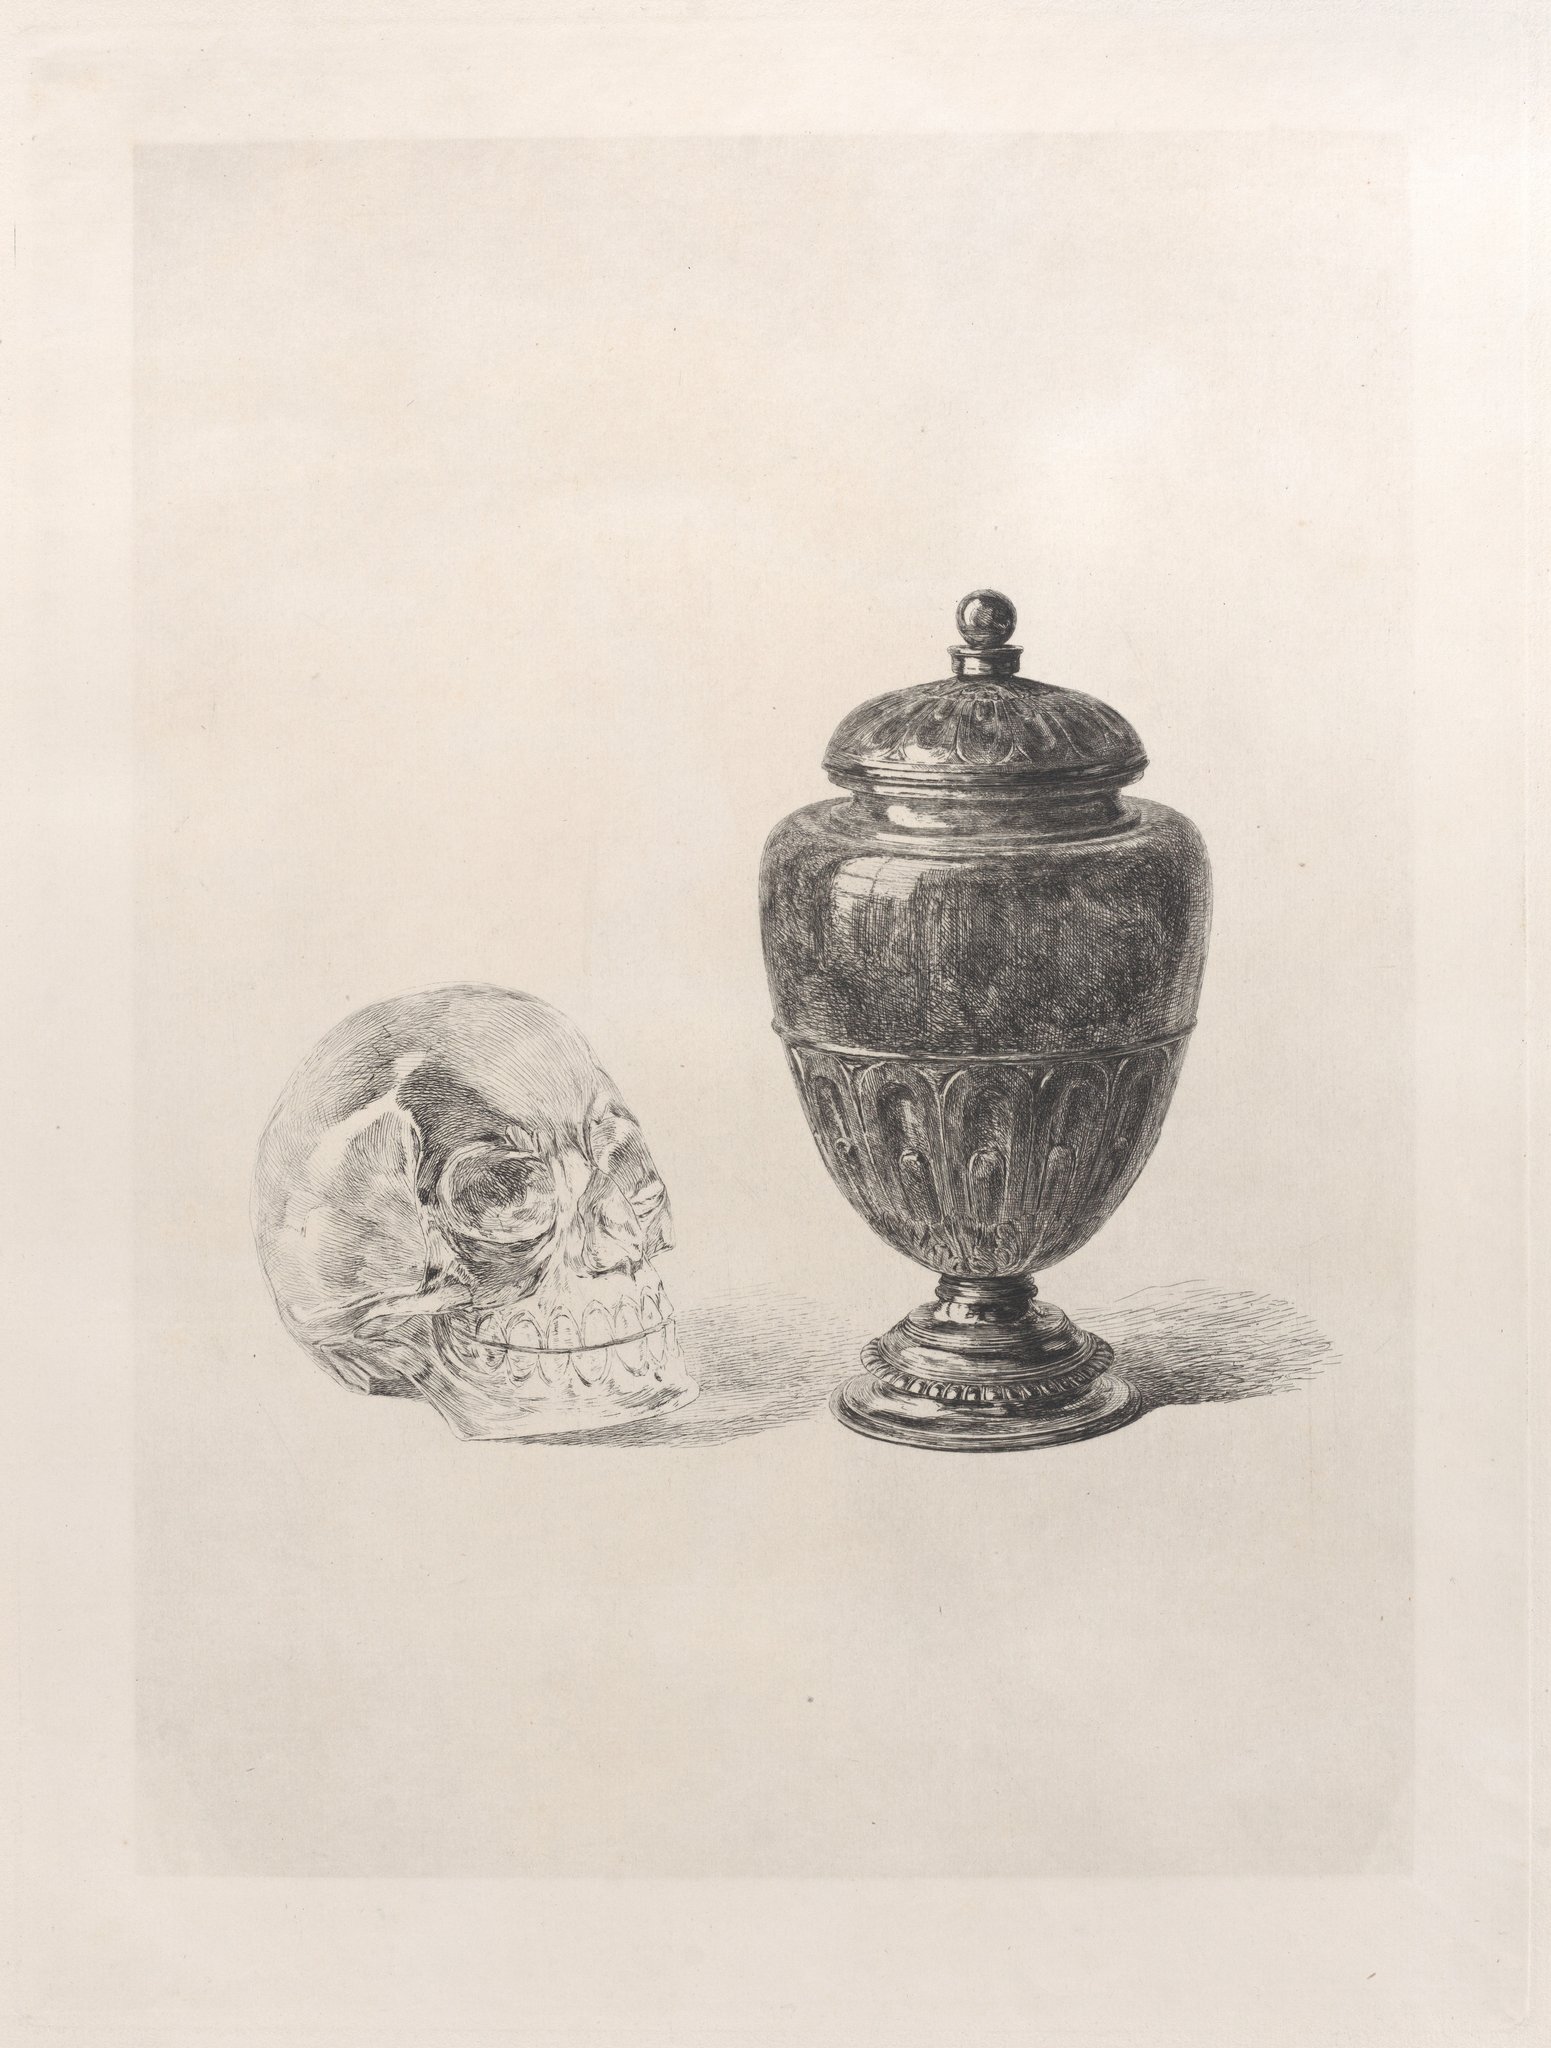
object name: print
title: Crystal Skull and Jade Vase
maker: jules-ferdinand jacquemart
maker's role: artist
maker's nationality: french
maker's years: 1837-1880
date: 1868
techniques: etching